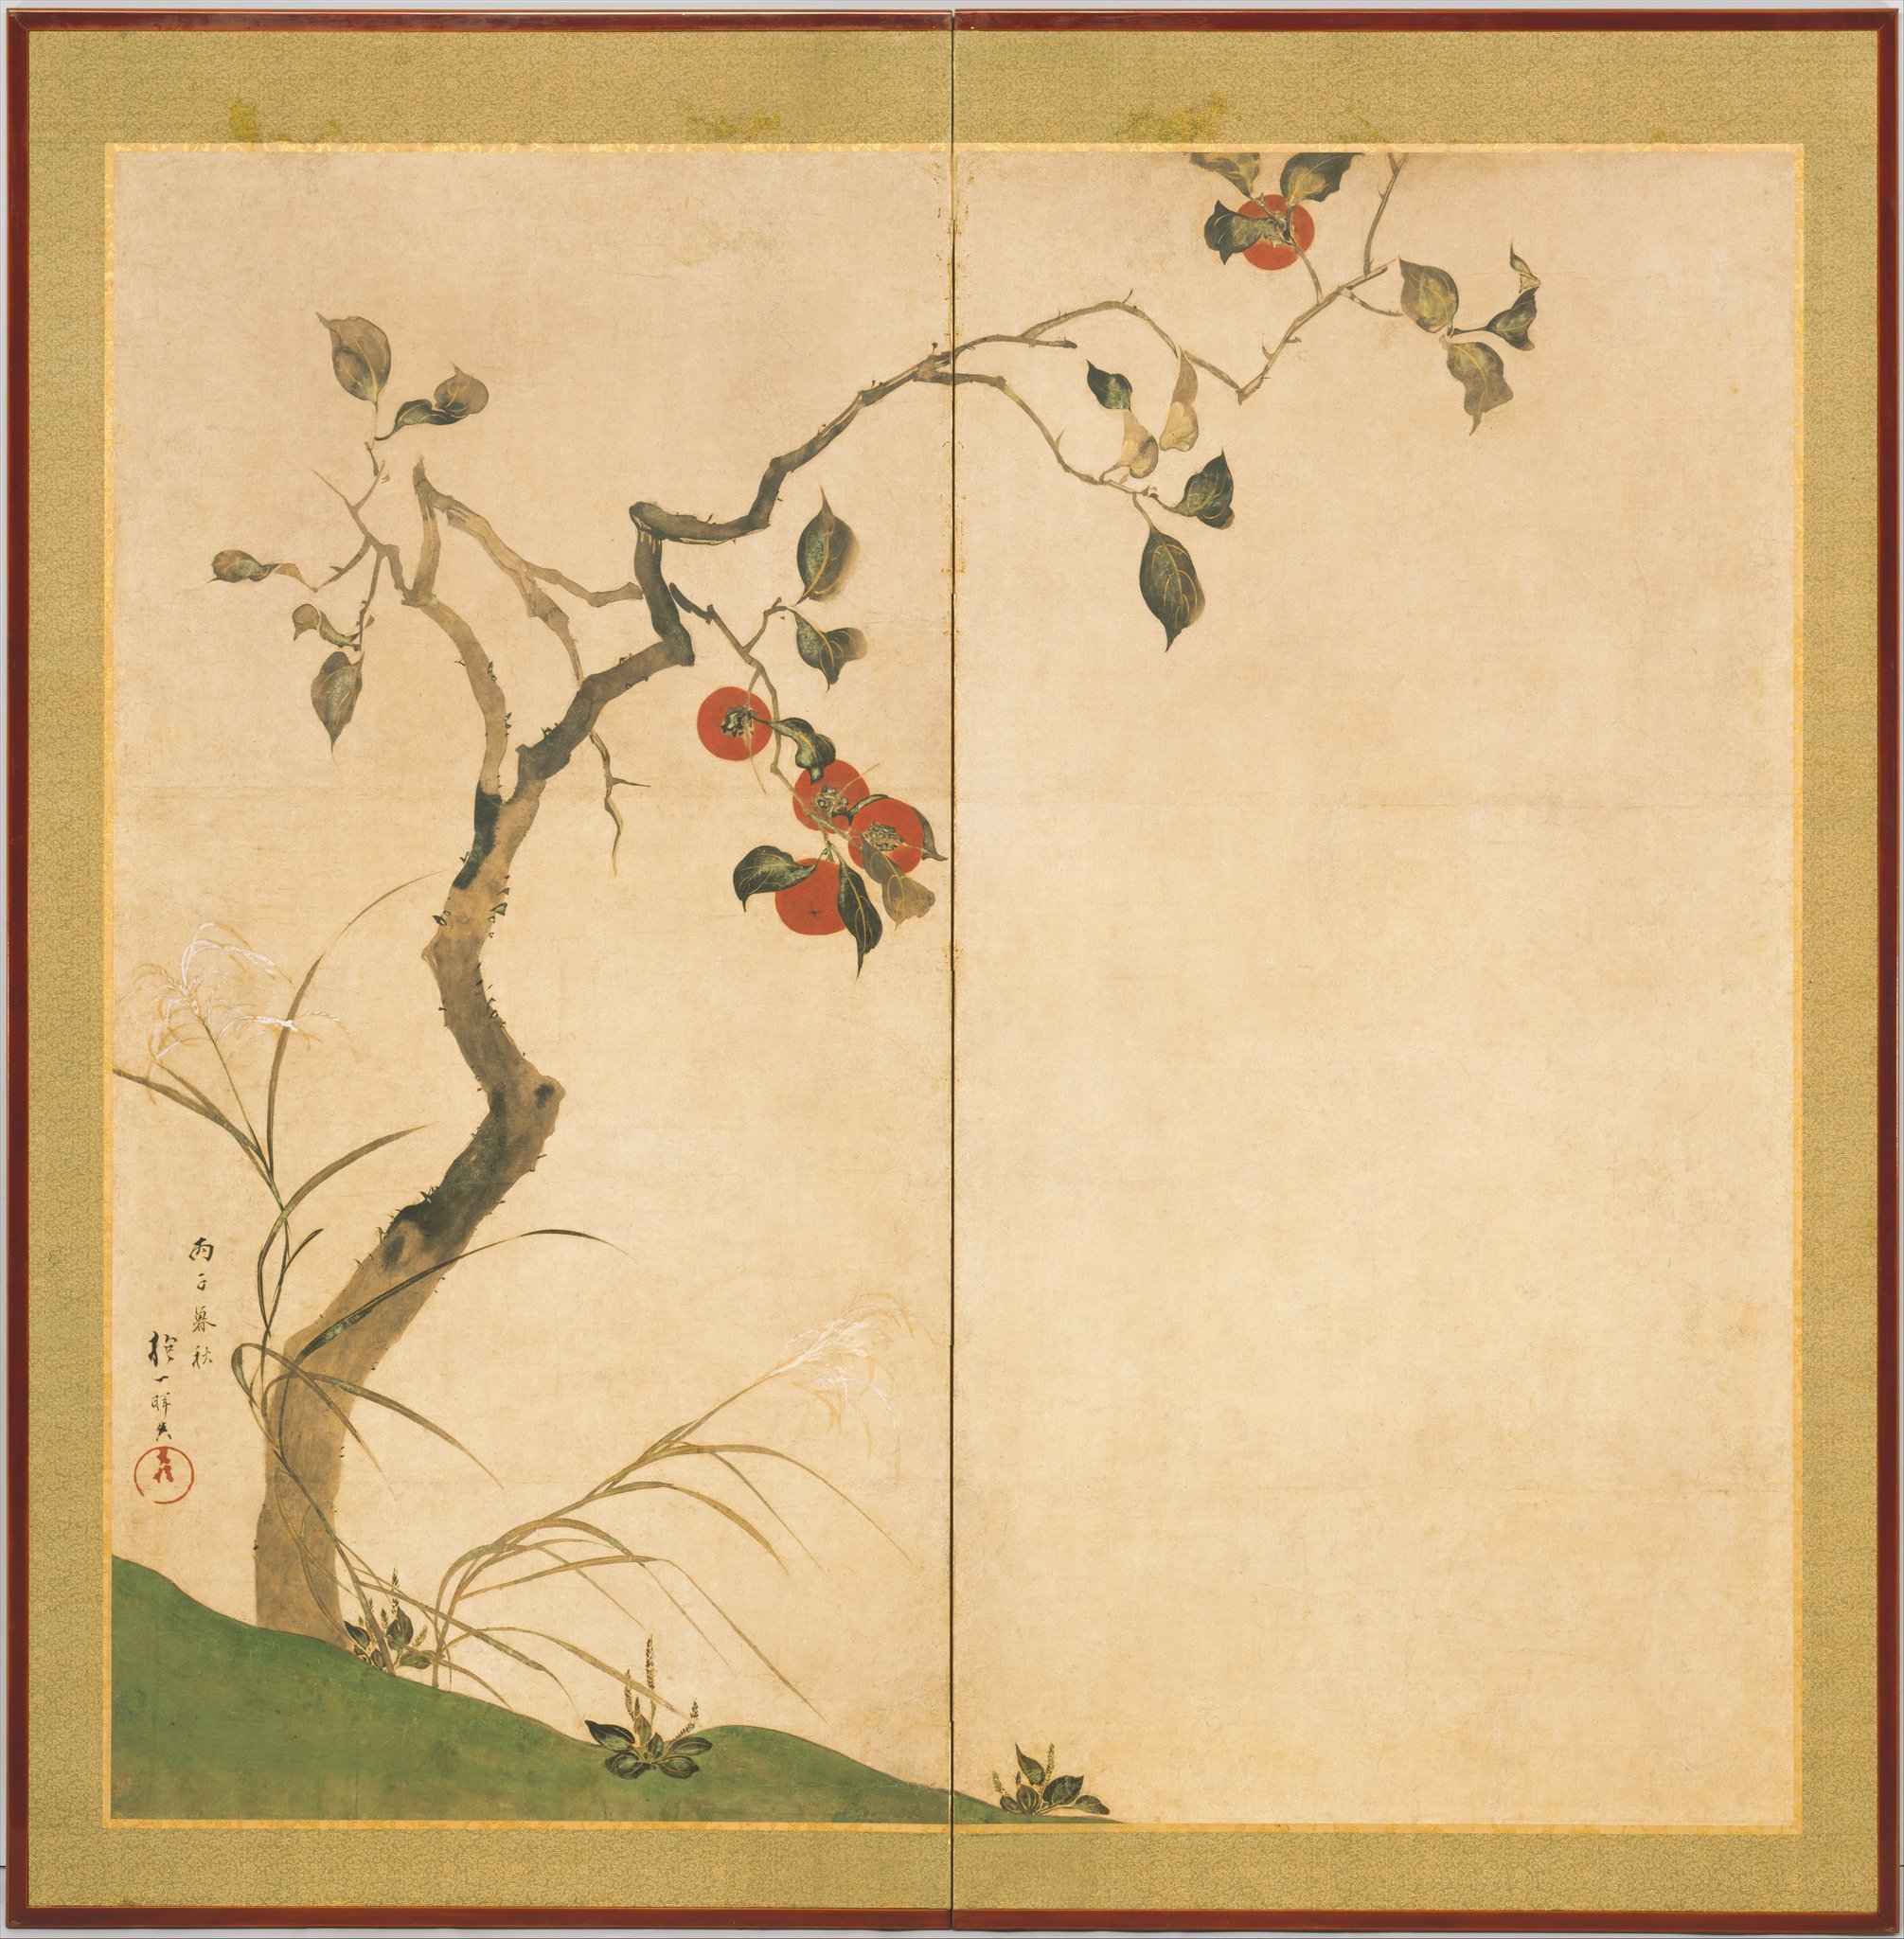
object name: screen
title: Persimmon Tree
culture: japanese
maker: sakai hōitsu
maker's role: artist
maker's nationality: japanese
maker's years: 1761-1828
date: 1816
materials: ink, panel, paper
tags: fruit,trees